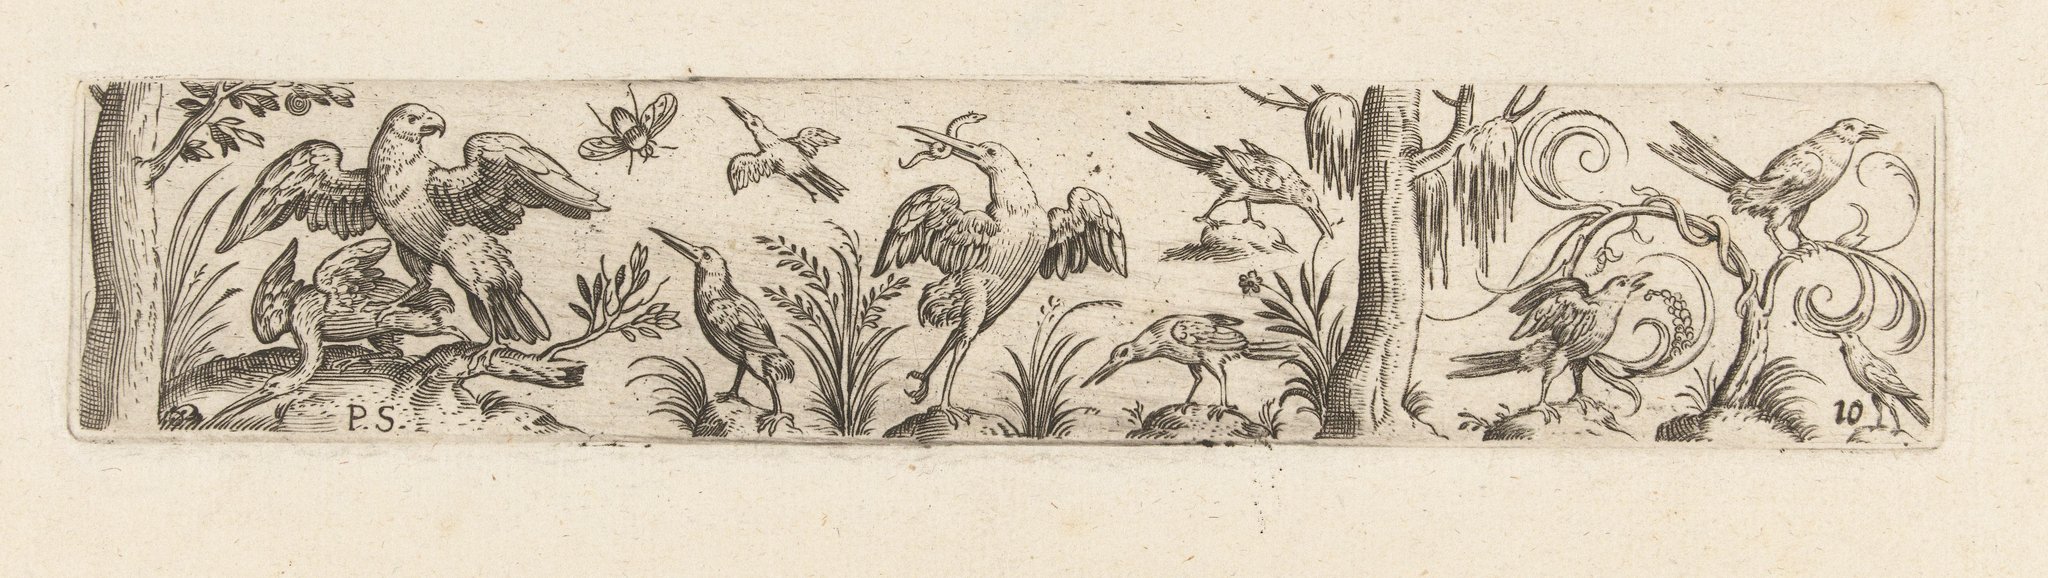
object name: print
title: Viel und mancherley Gefögel den Malern und Goltsmiden dienlich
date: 1607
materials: paper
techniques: engraving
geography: netherlands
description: Aan het linker uiteinde van het fries staat een boom. Rechts staan een boom en een struikje. Nummer 10 uit serie van 12 genummerde bladen.